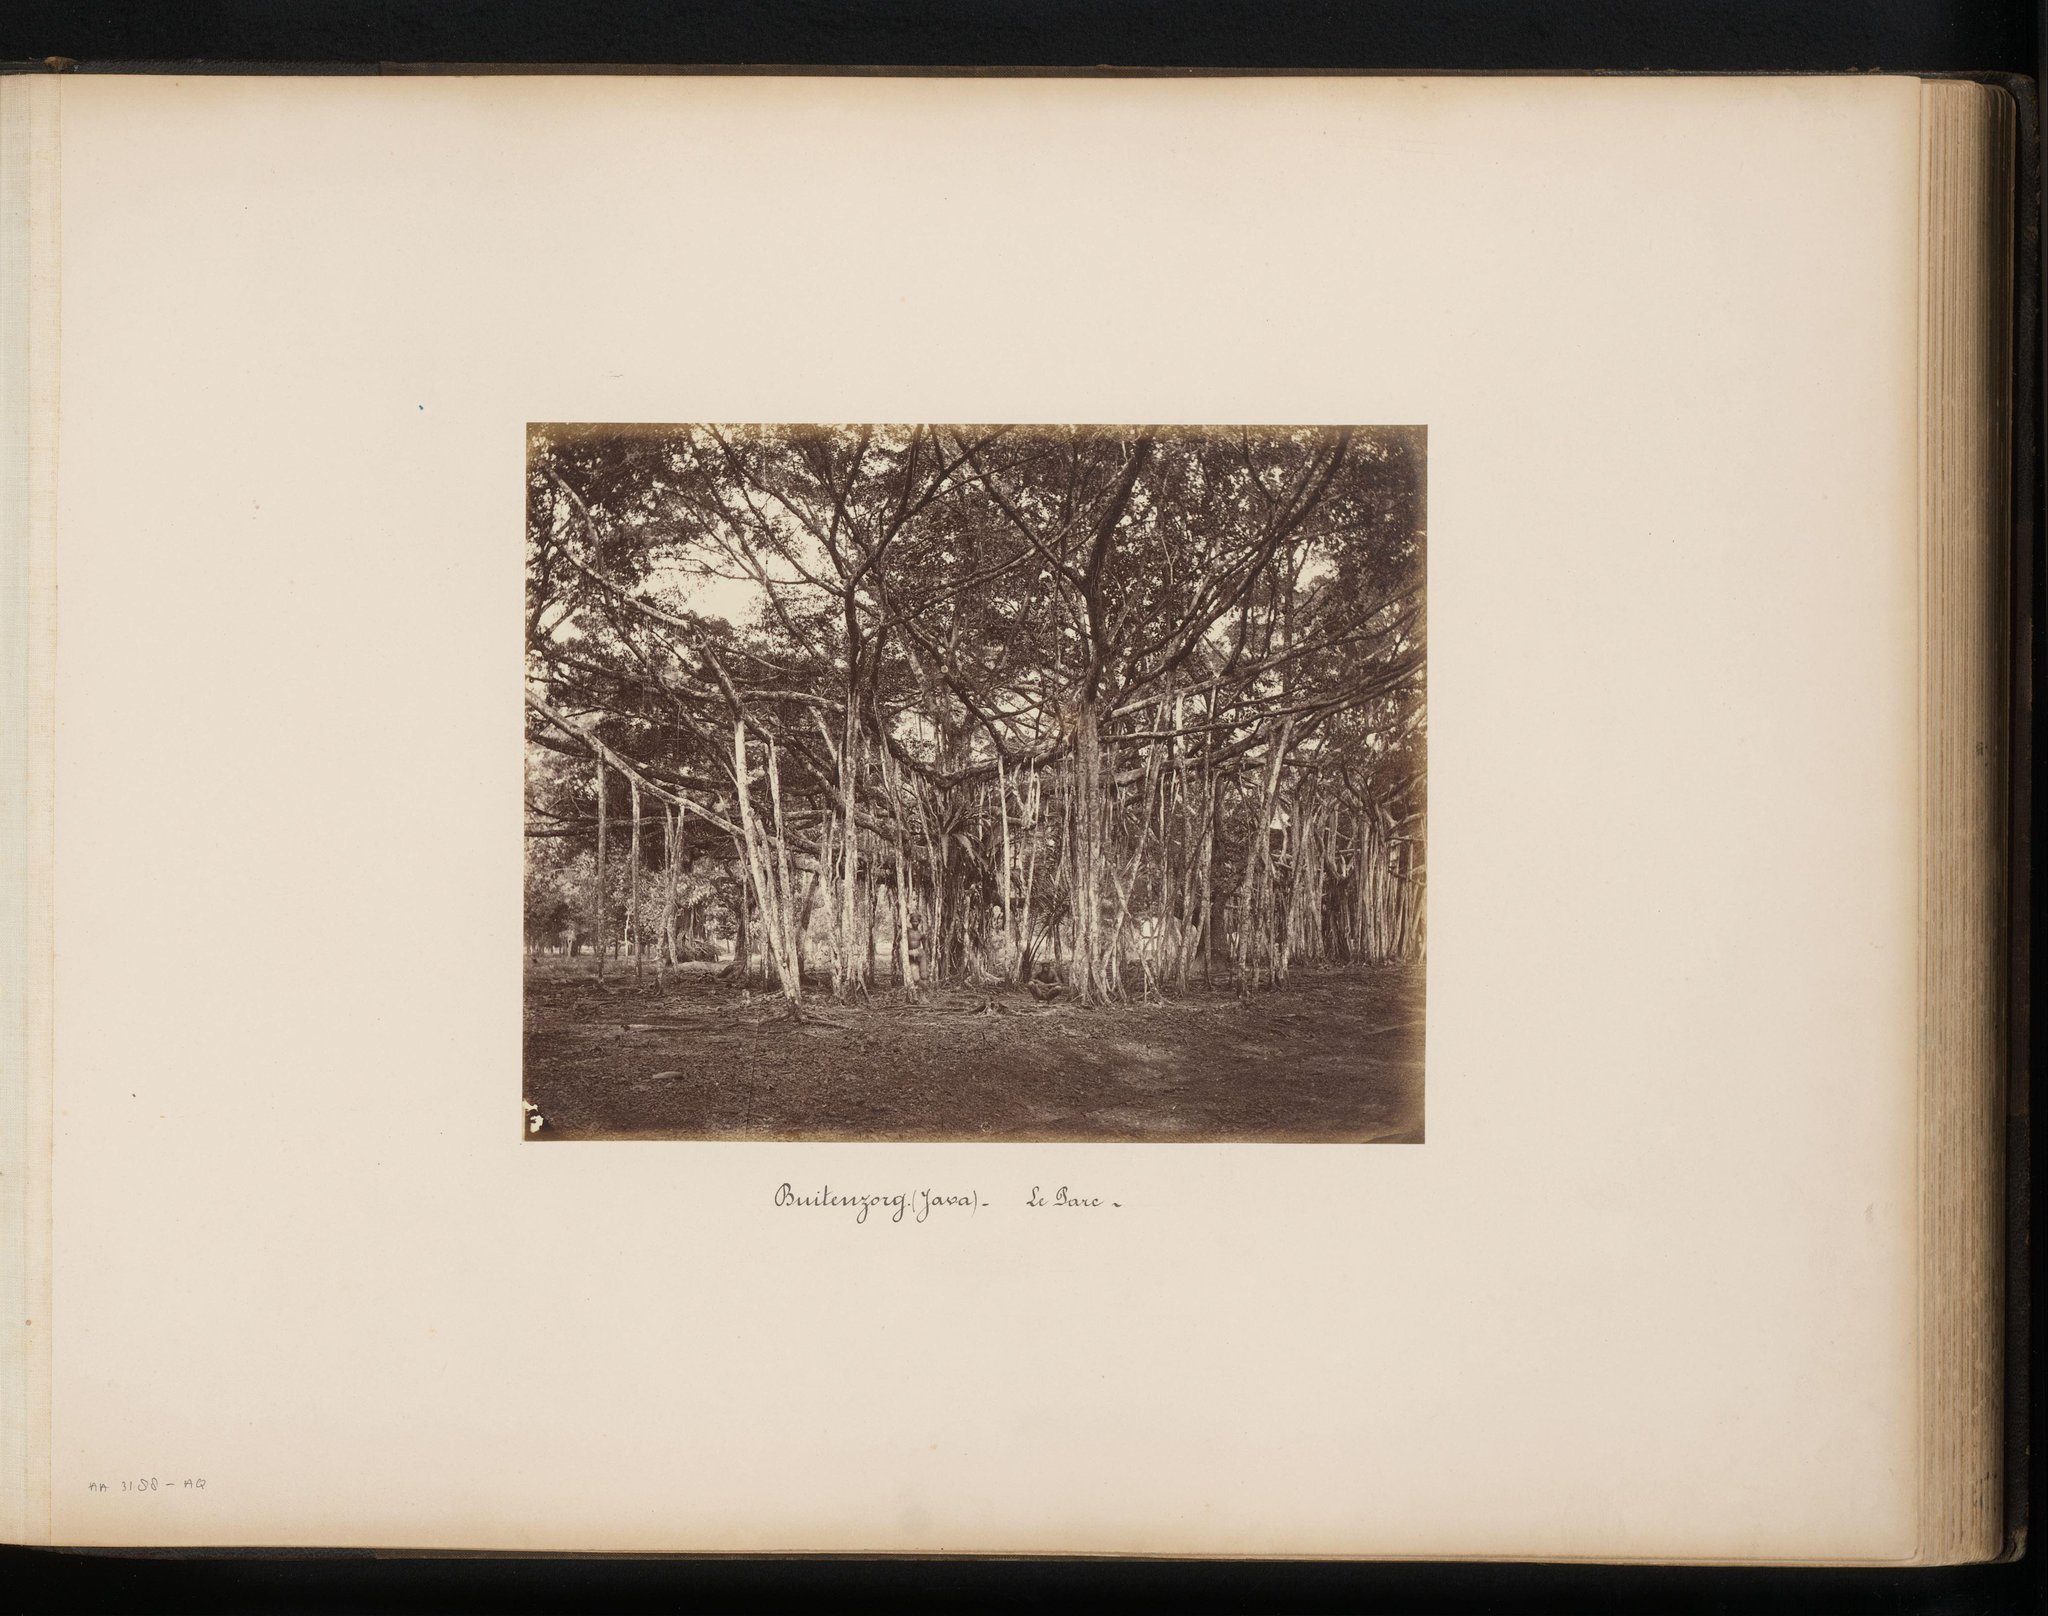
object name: photograph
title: Waringins in het park van de gouverneur-generaal te Buitenzorg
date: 1880-1883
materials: photographic support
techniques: albumen print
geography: buitenzorg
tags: trees, public gardens, park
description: Onderdeel van Reisalbum met opnames van bezienswaardigheden in Egypte, Nederlands-Indië, Singapore en Ceylon.